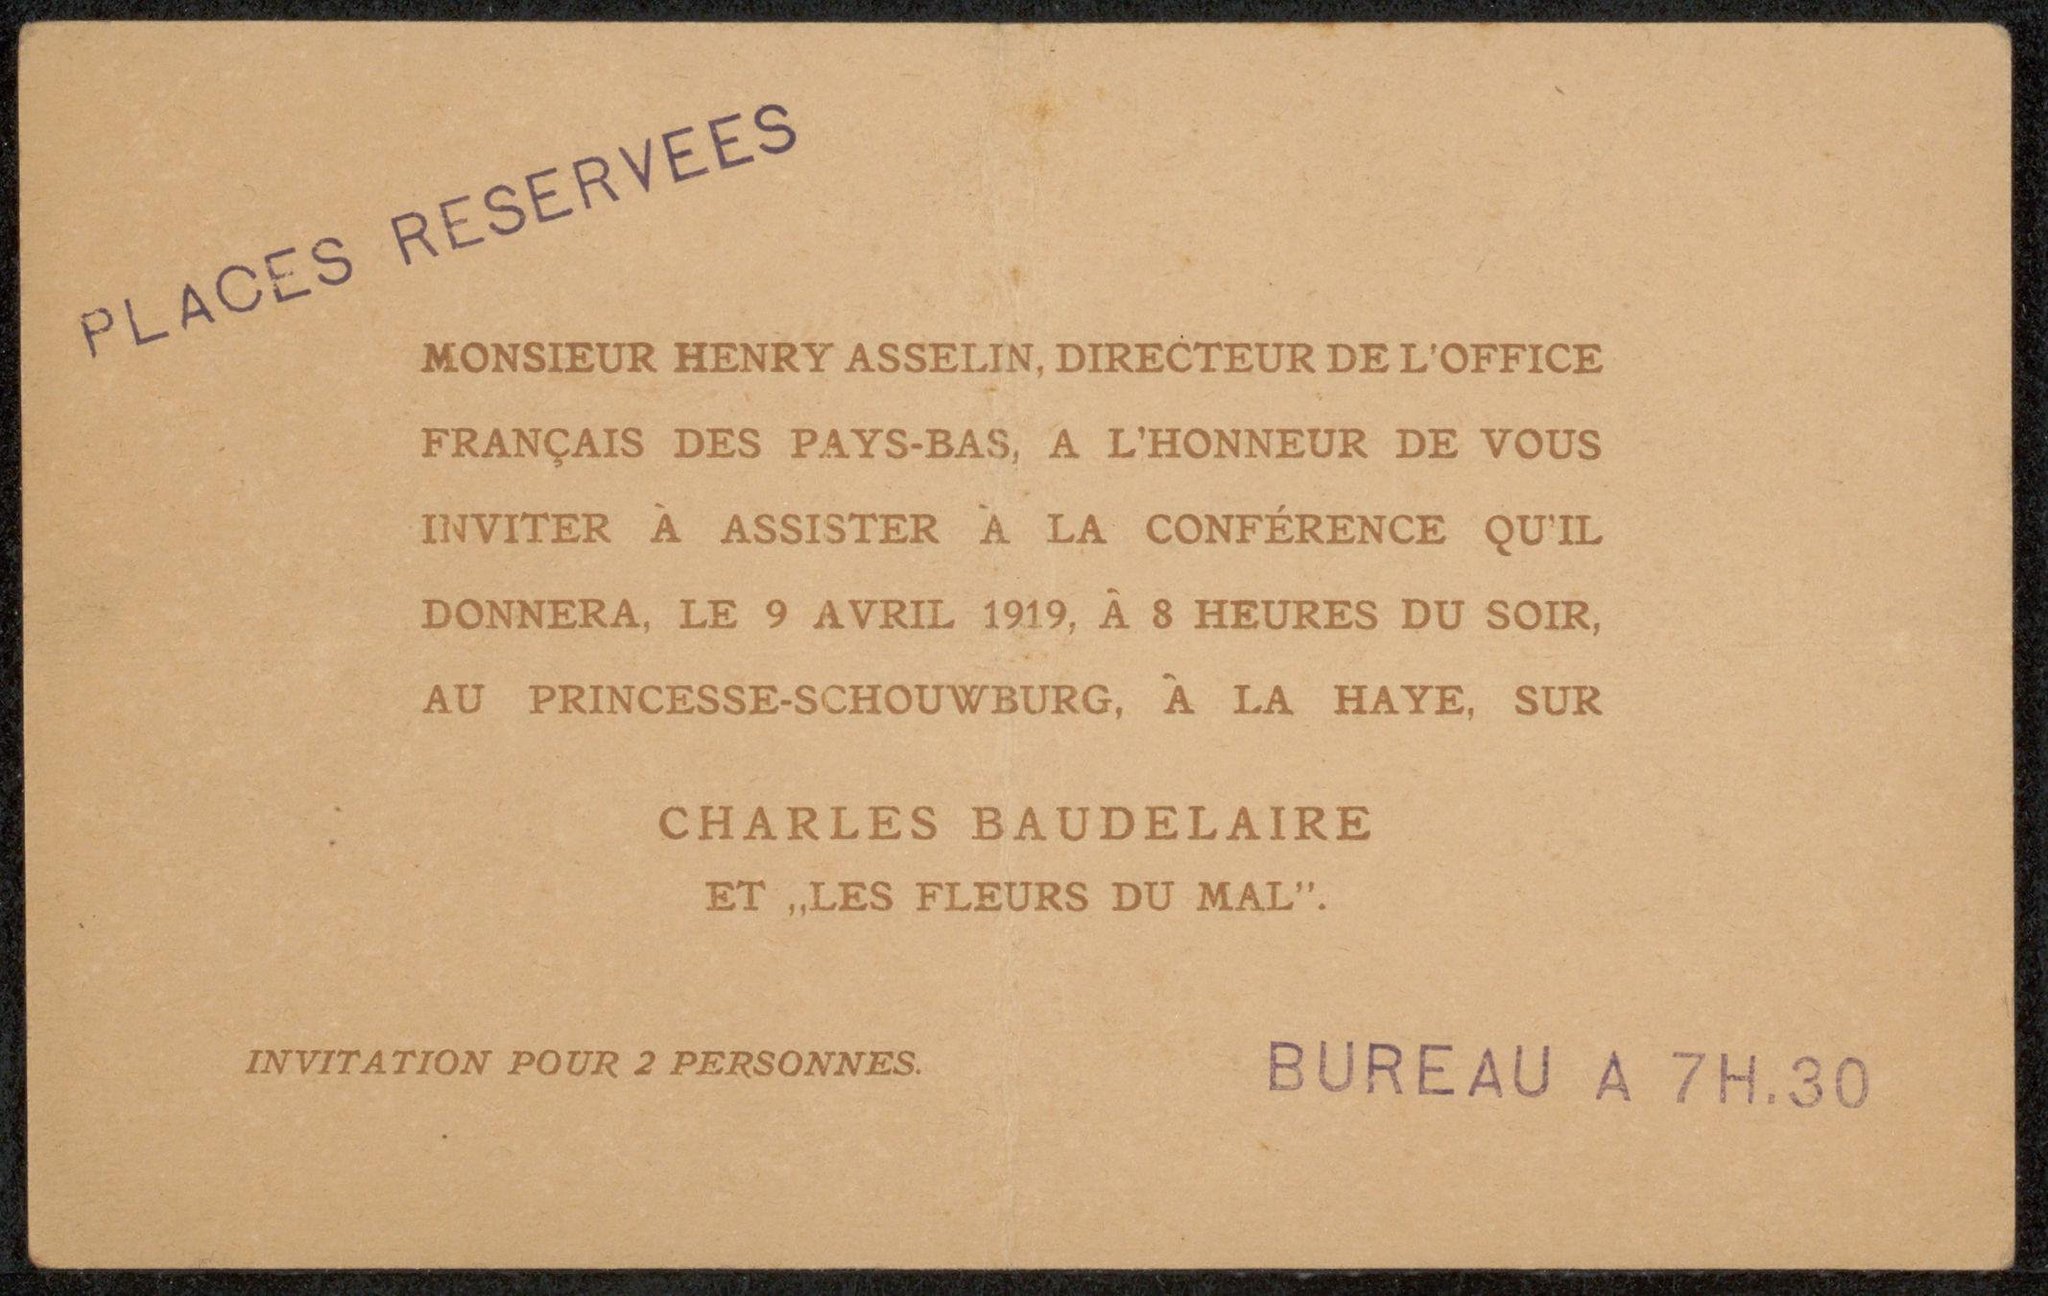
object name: invitation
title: Uitnodiging aan Philip Zilcken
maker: henry asselin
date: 1919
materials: cardboard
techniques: printing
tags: paris, charles baudelaire, the hague, painter, draughtsman, philip zilcken